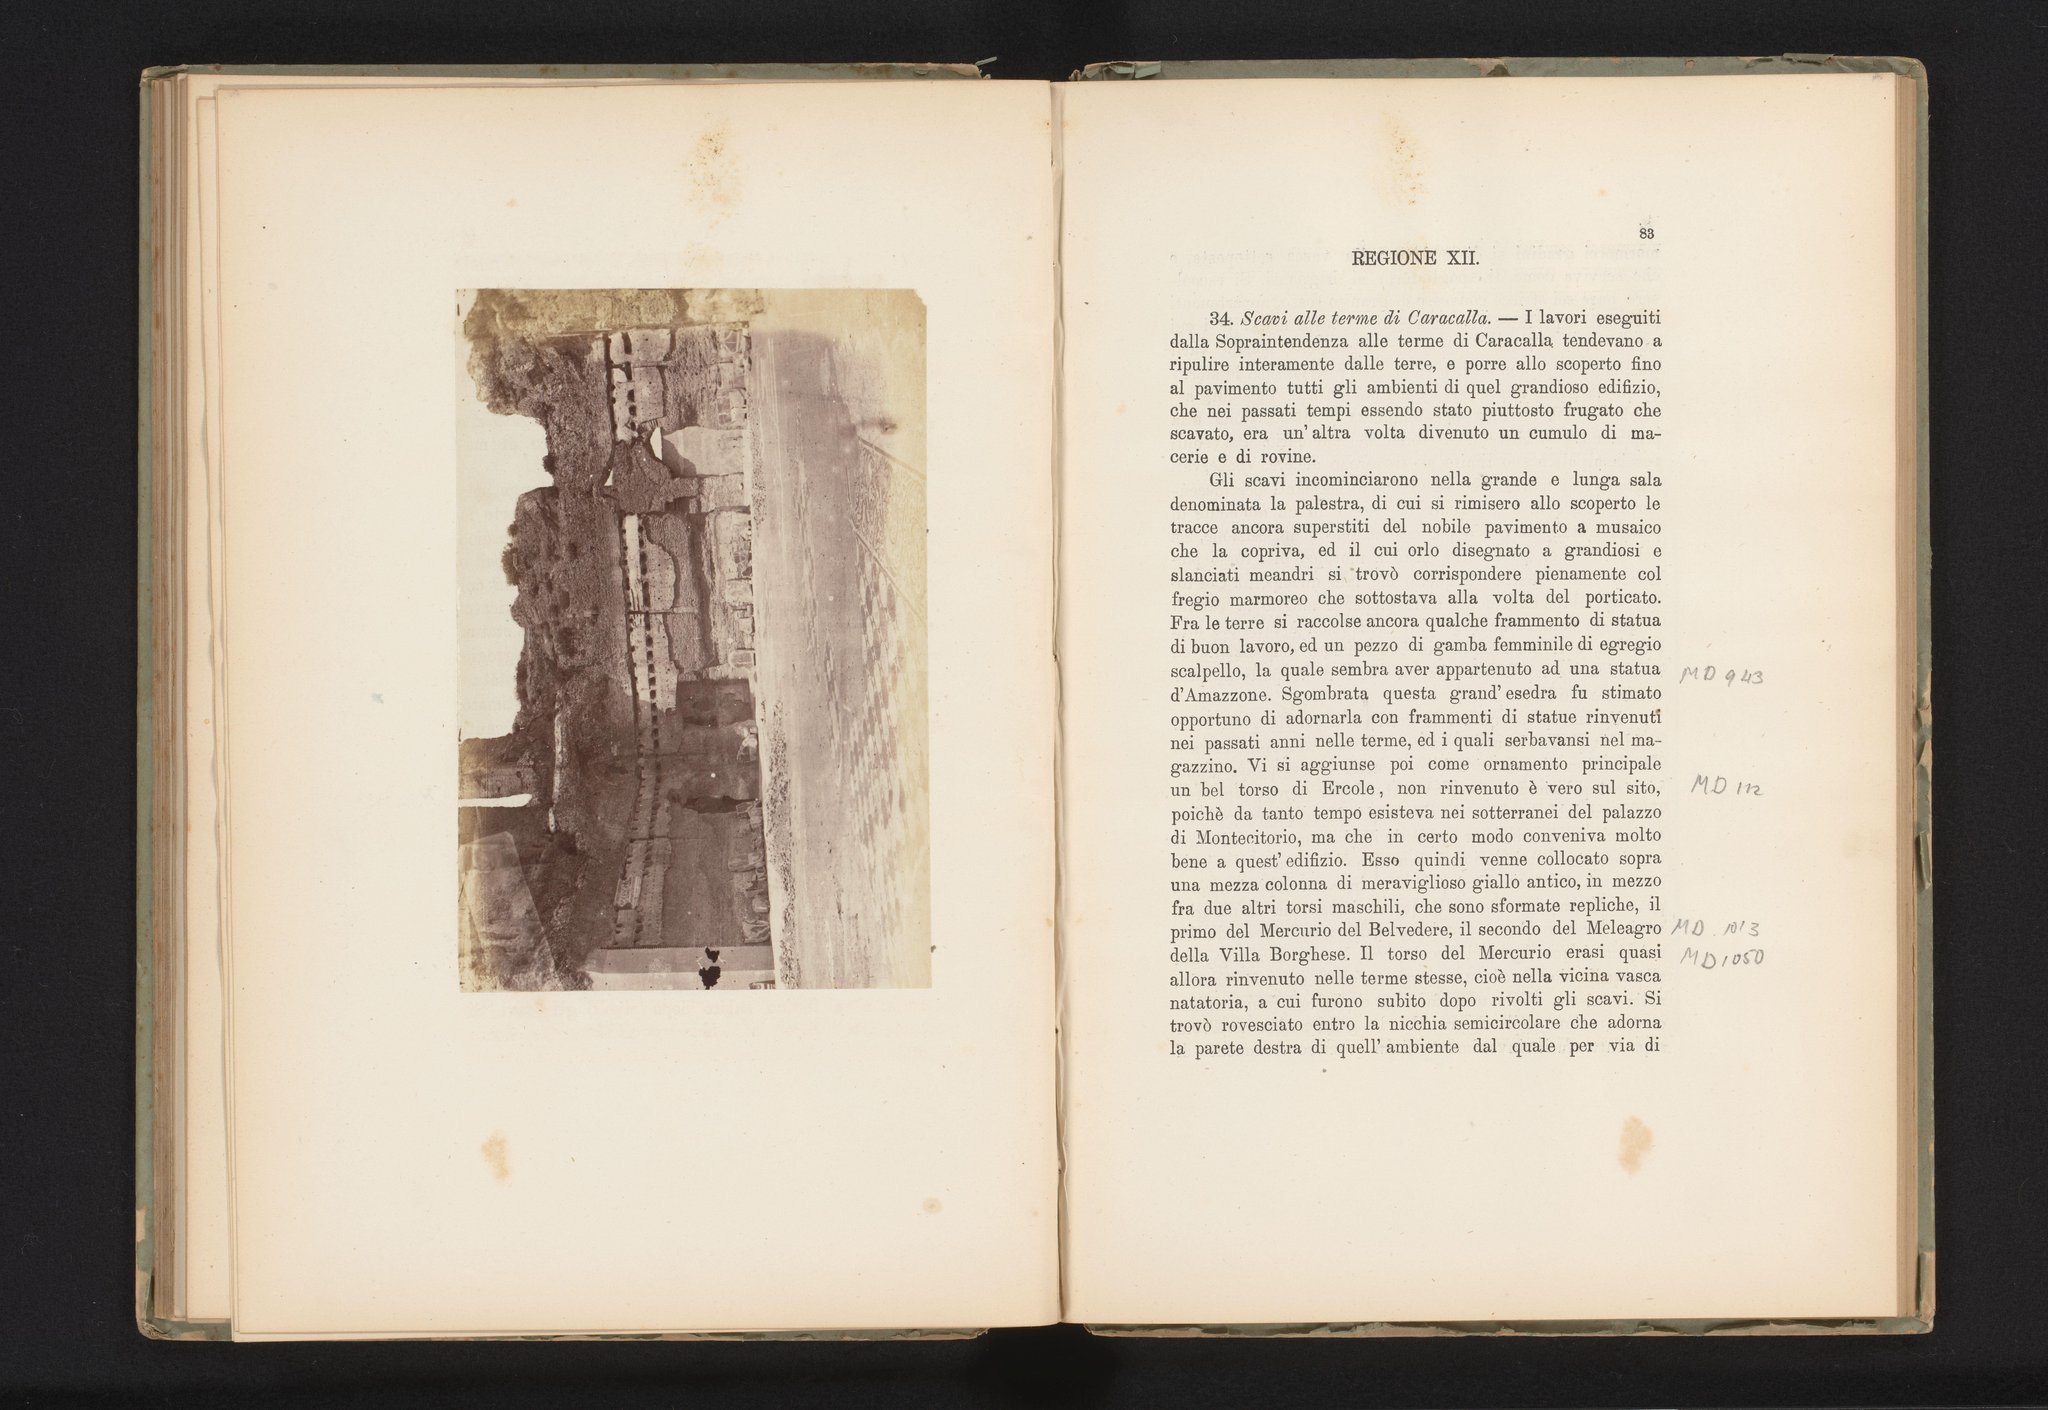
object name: photograph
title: Ruïne van de Thermen van Caracalla op de Aventijn te Rome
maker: Anonymous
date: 1863-1873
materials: photographic support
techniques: albumen print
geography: aventijn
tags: ruin of a building ~ architecture, public baths